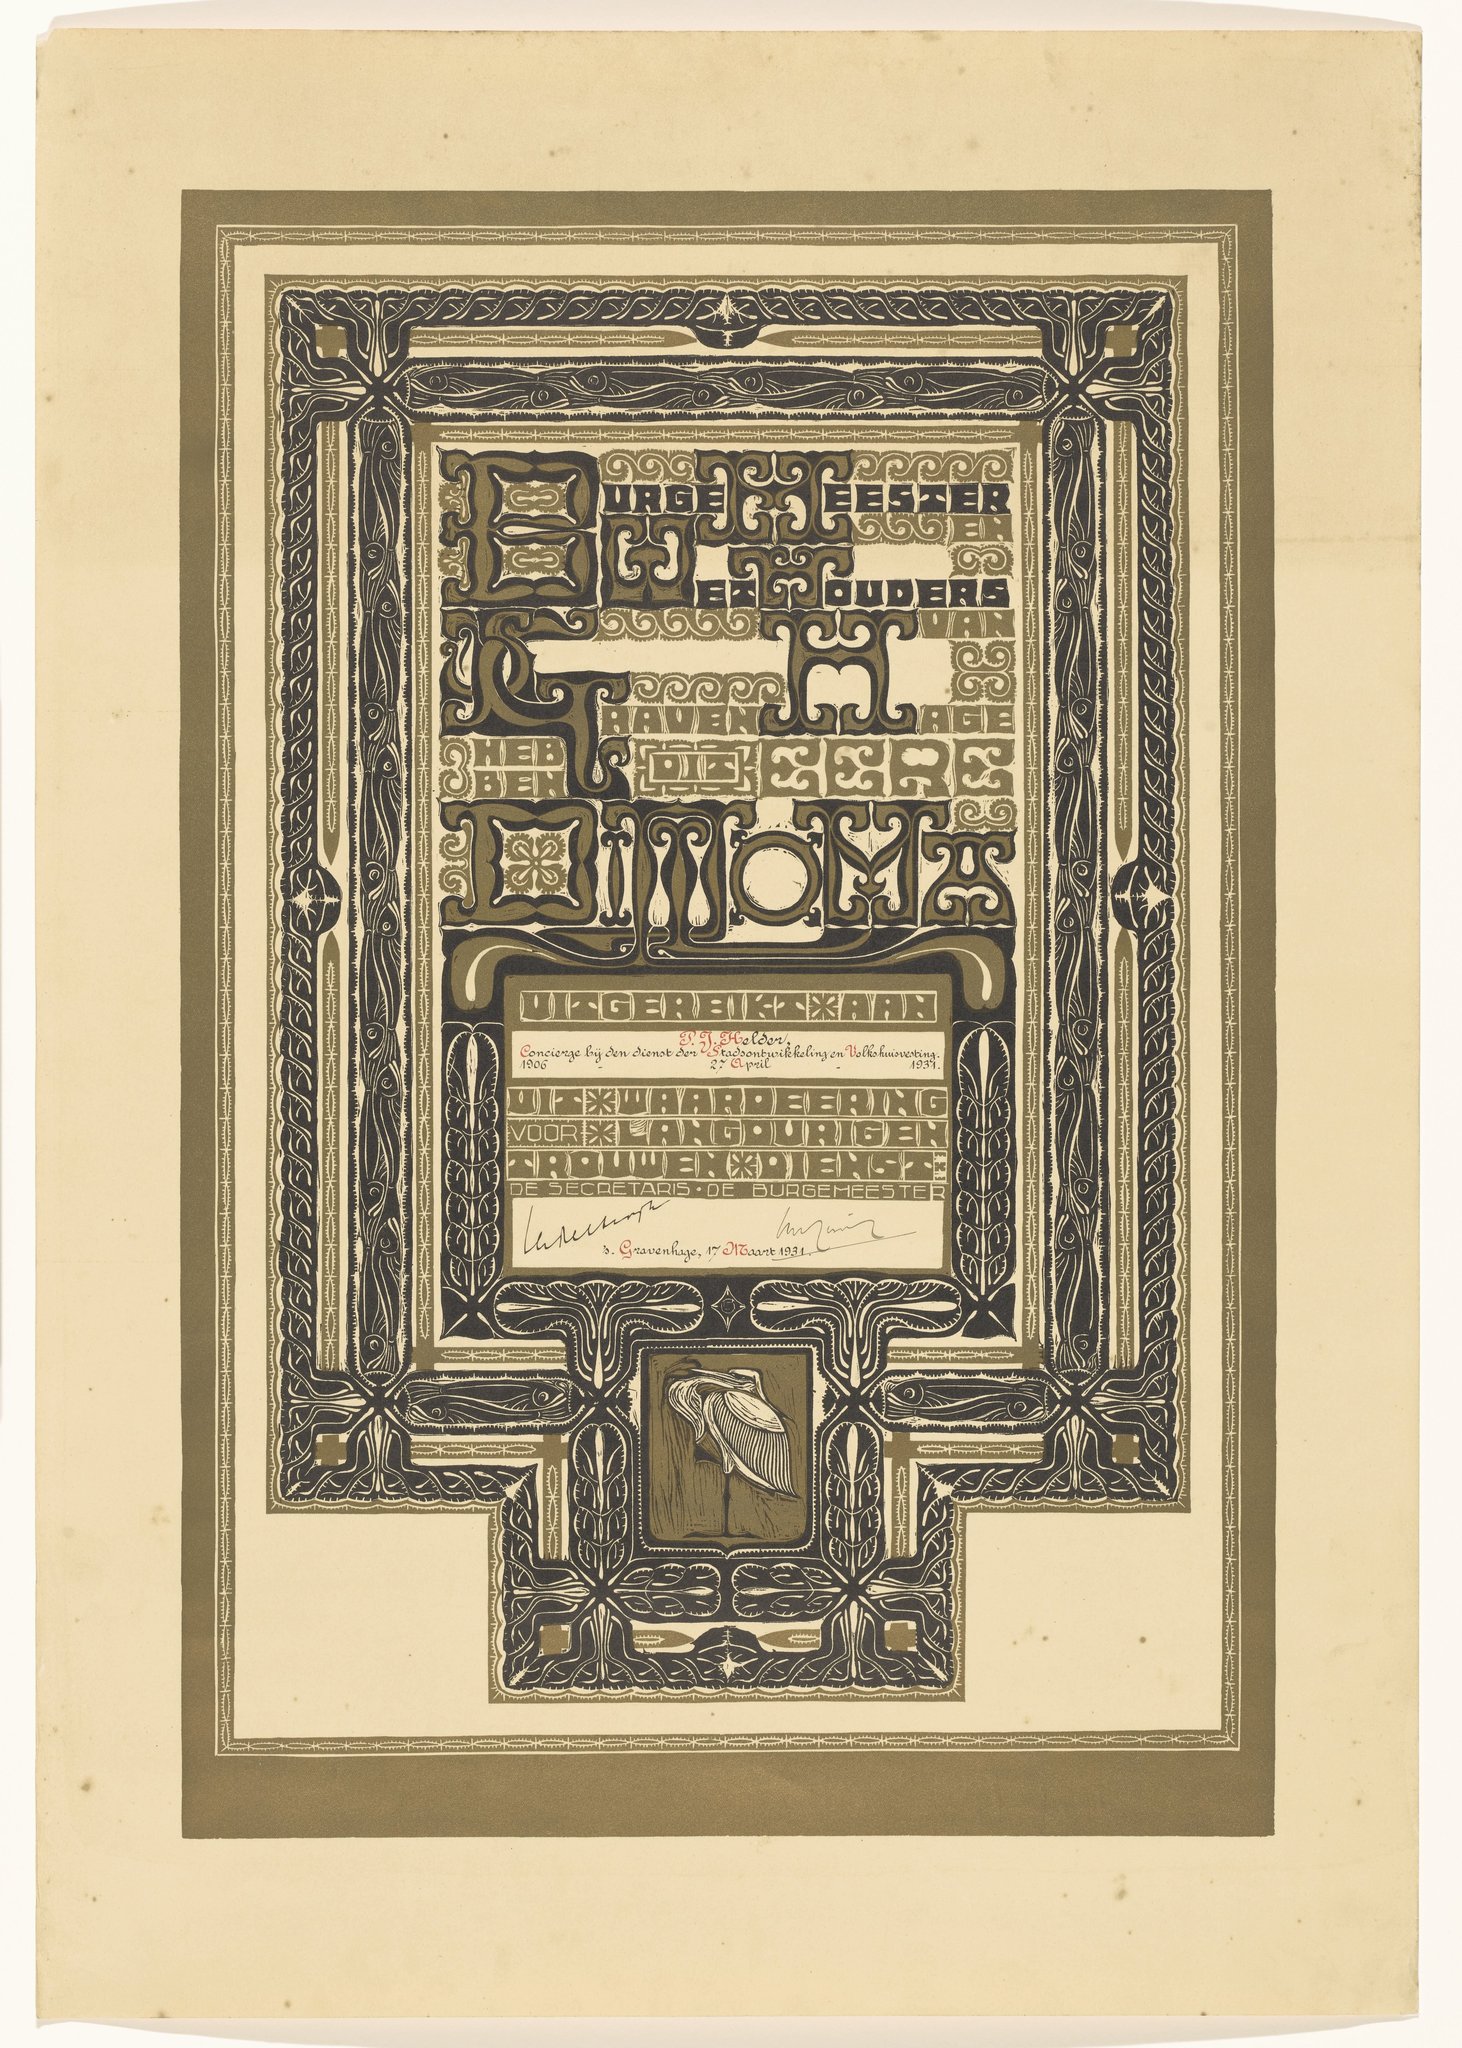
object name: certificate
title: Diploma bij 25-jarig ambtsjubileum, 1931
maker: chris lebeau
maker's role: draughtsman, print maker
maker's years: 1878-1945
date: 1880-1931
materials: paper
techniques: chromolithography, handwriting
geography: netherlands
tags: shore-birds and wading-birds: stork, the hague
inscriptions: collector's mark: Lugt 2228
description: Erediploma uitgereikt door burgemeester en wethouders van 's-Gravenhage aan P.J. Helder, concierge bij de Dienst der Stadsontwikkeling en Volkshuisvesting, op 27 april 1931 wegens langdurige en trouwe dienst. Voorgedrukte diploma met de hand ingevuld. Onderaan een ooievaar.